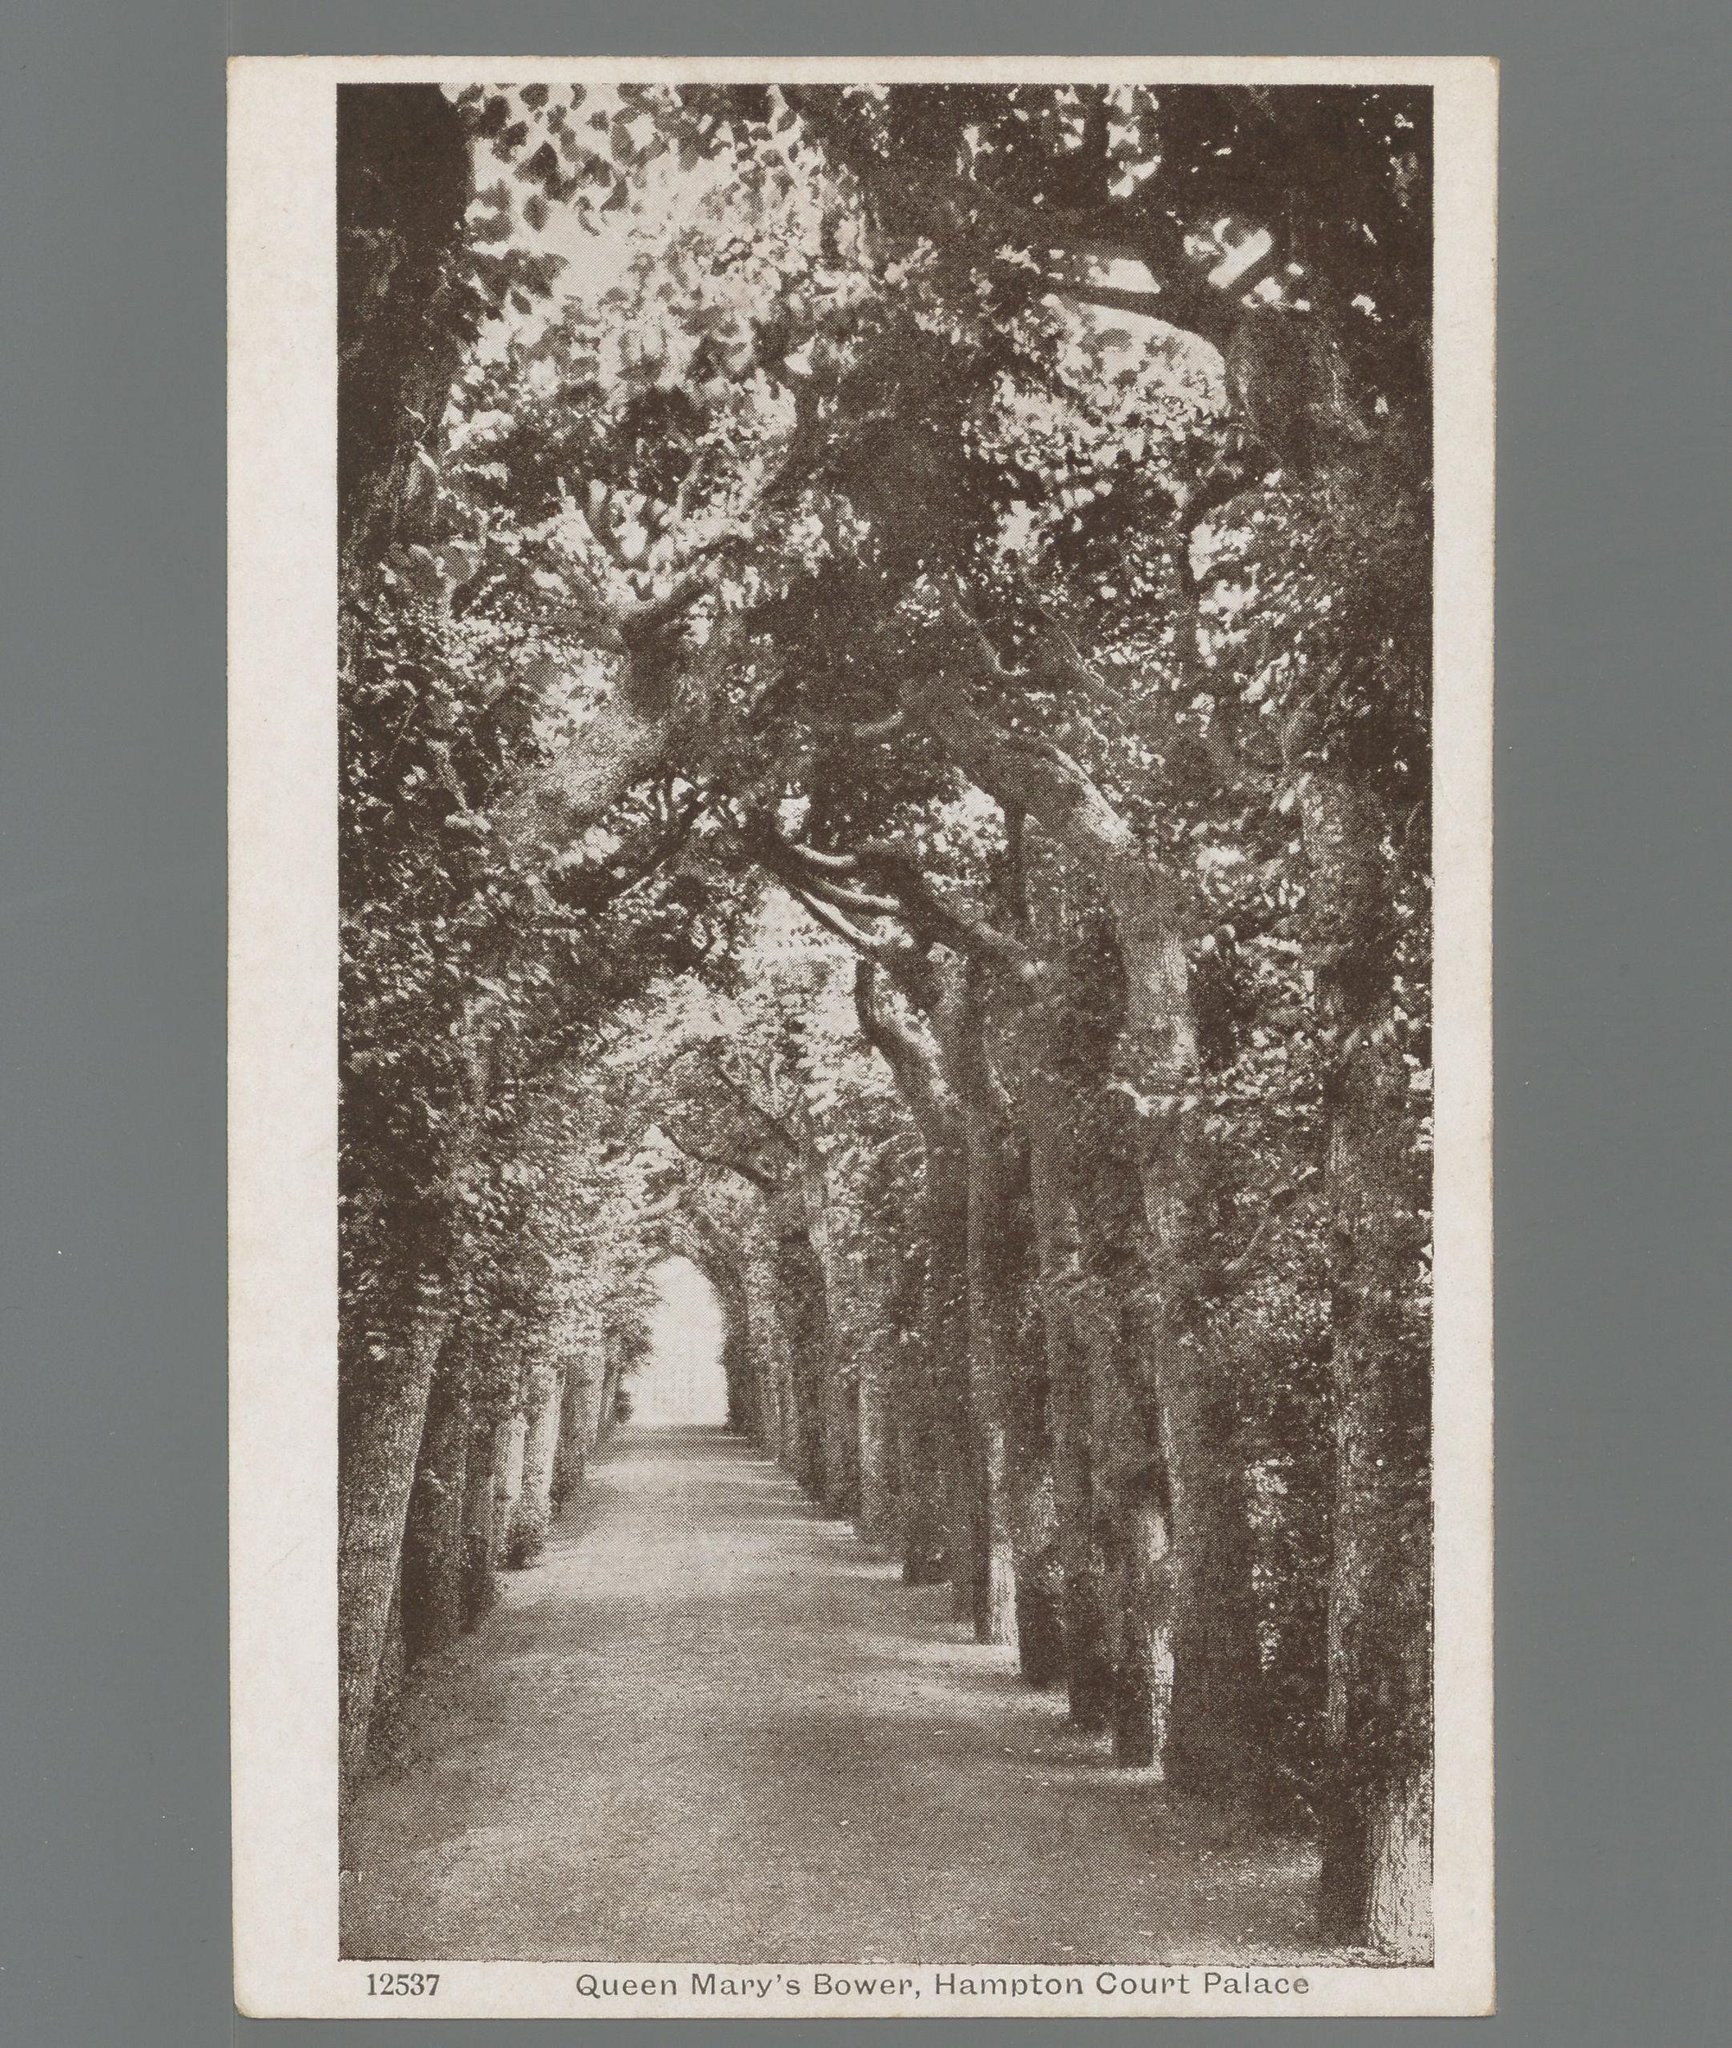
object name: photomechanical print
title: The G&P Series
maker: Anonymous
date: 1915-1930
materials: cardboard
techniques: autotype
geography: london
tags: trees, garden, road, path